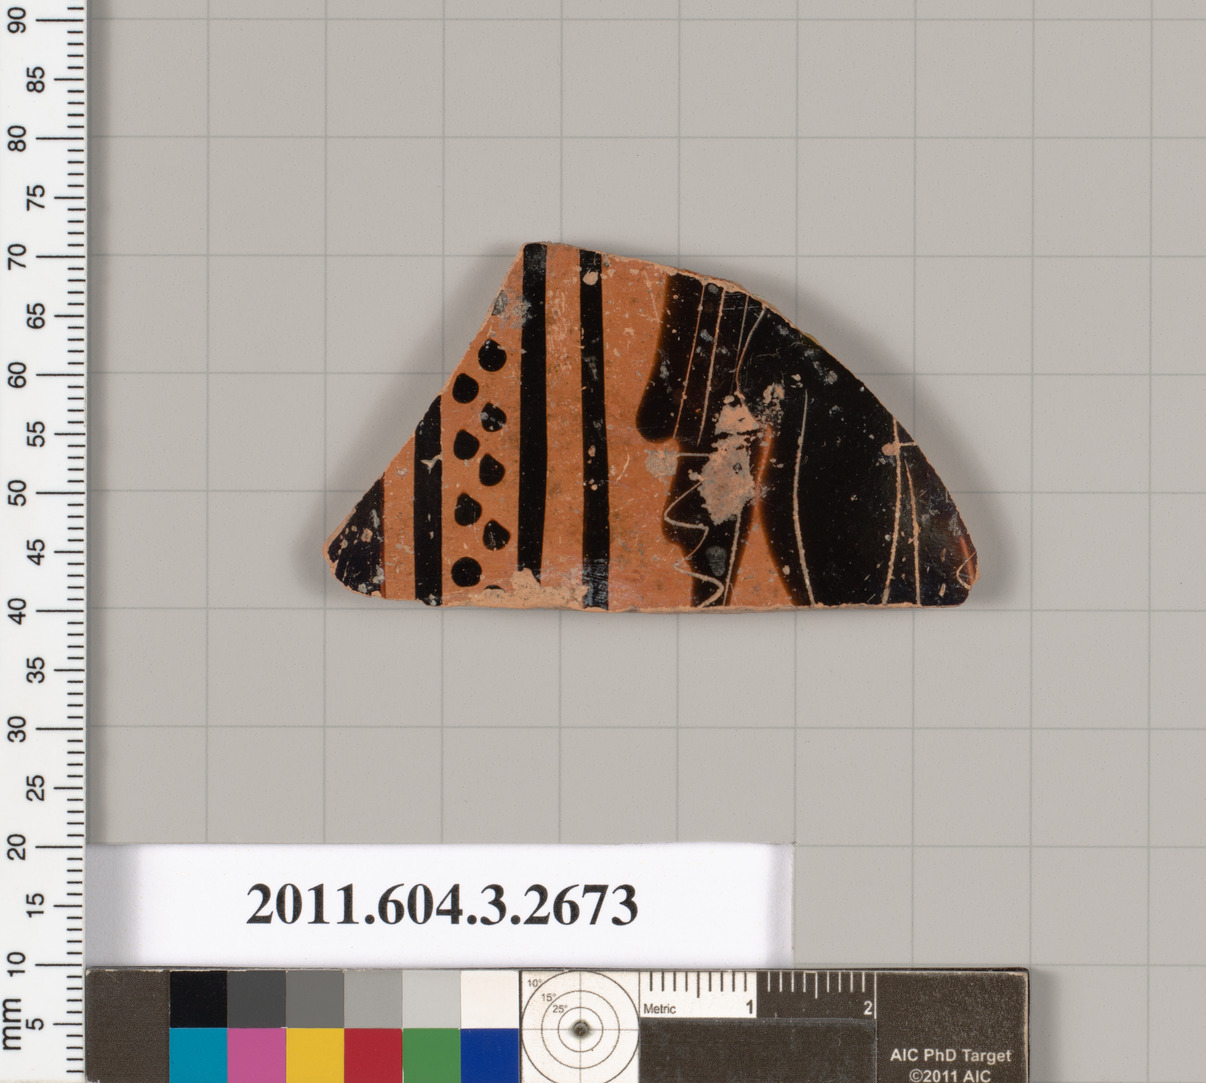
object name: olpe fragment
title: Terracotta fragment of an olpe (jug)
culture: greek, attic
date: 510-500 BCE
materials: terracotta